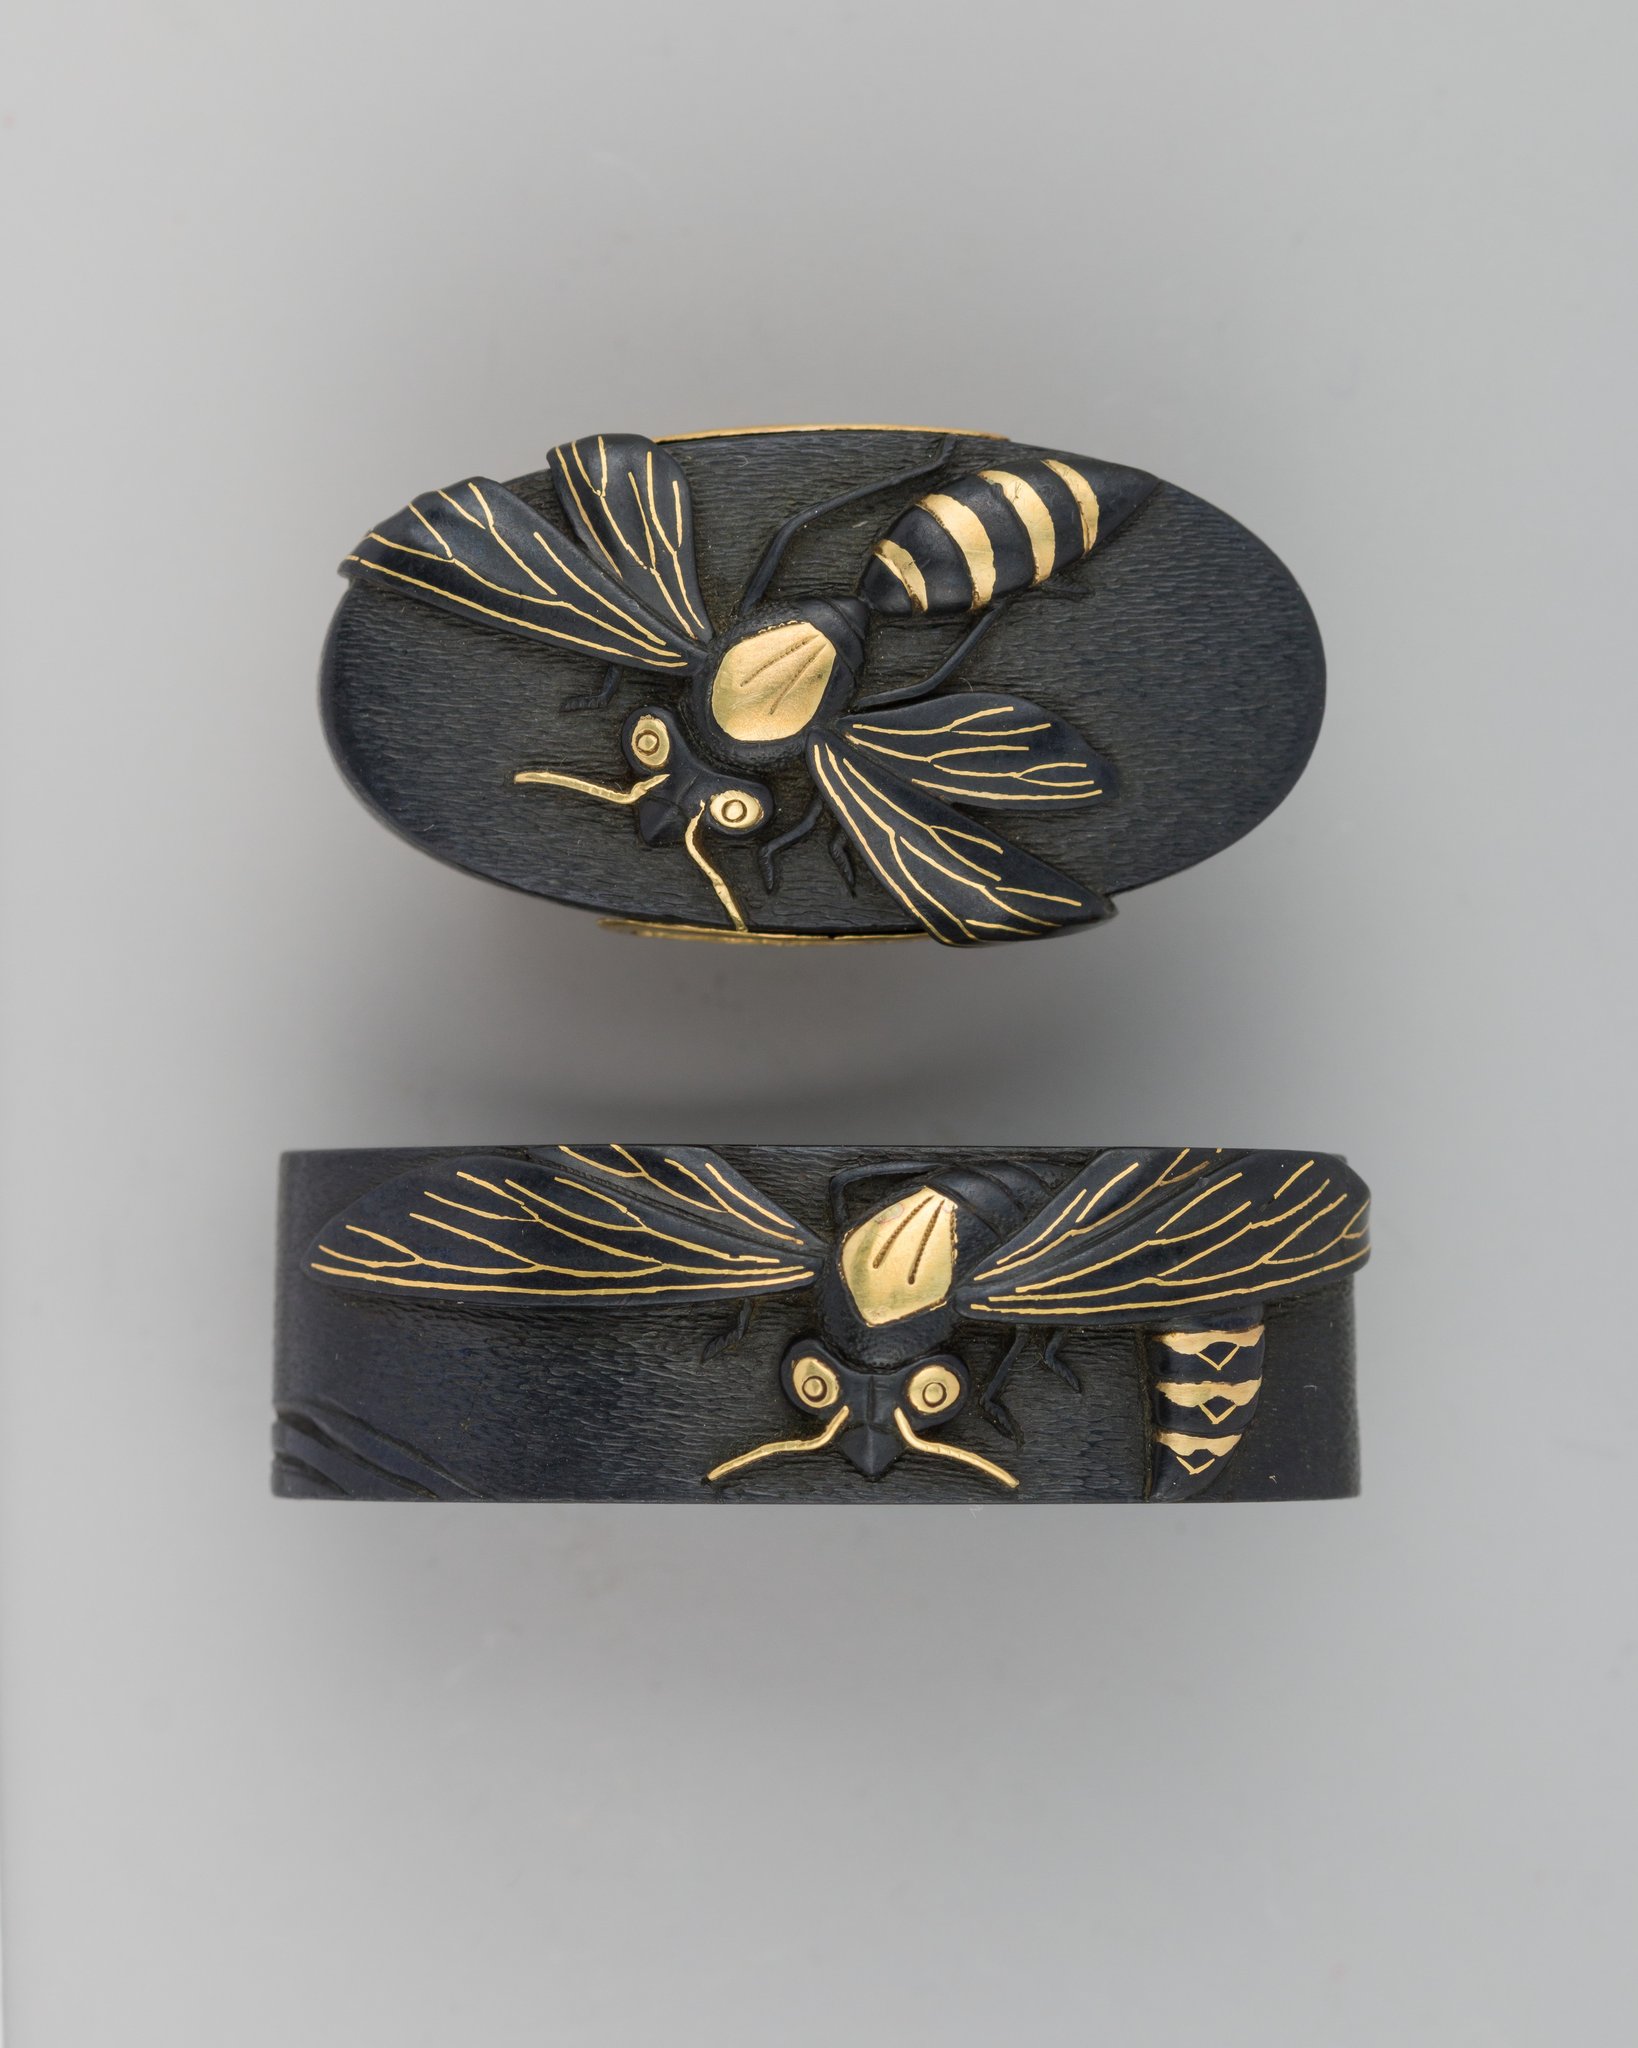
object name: sword hilt collar and pommel fuchigashira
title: Sword-Hilt Collar and Pommel (Fuchigashira)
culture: japanese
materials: copper, gold alloy, gold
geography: japan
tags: bees